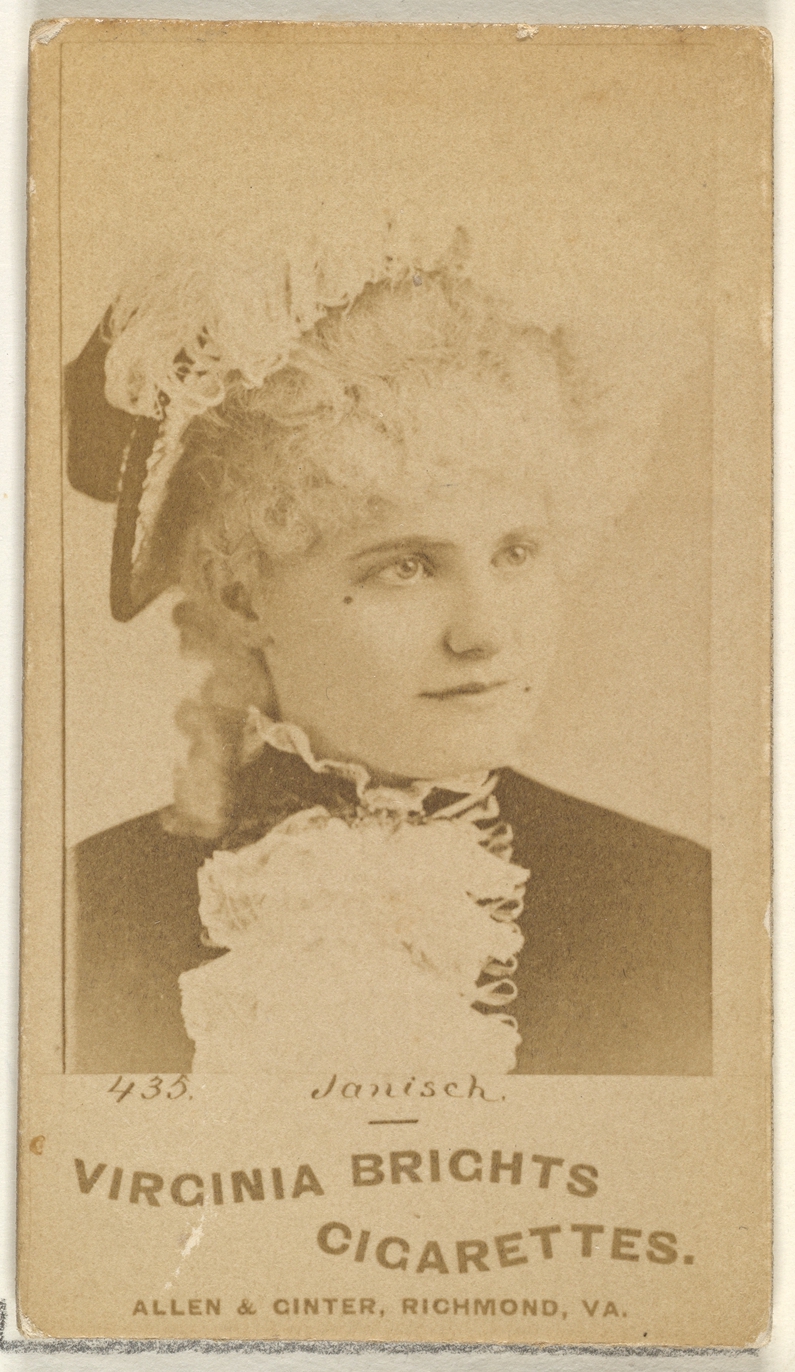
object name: photograph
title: Card 435, Janisch, from the Actors and Actresses series (N45, Type 1) for Virginia Brights Cigarettes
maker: allen & ginter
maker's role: publisher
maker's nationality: american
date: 1888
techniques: albumen silver print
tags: portraits,women,actresses